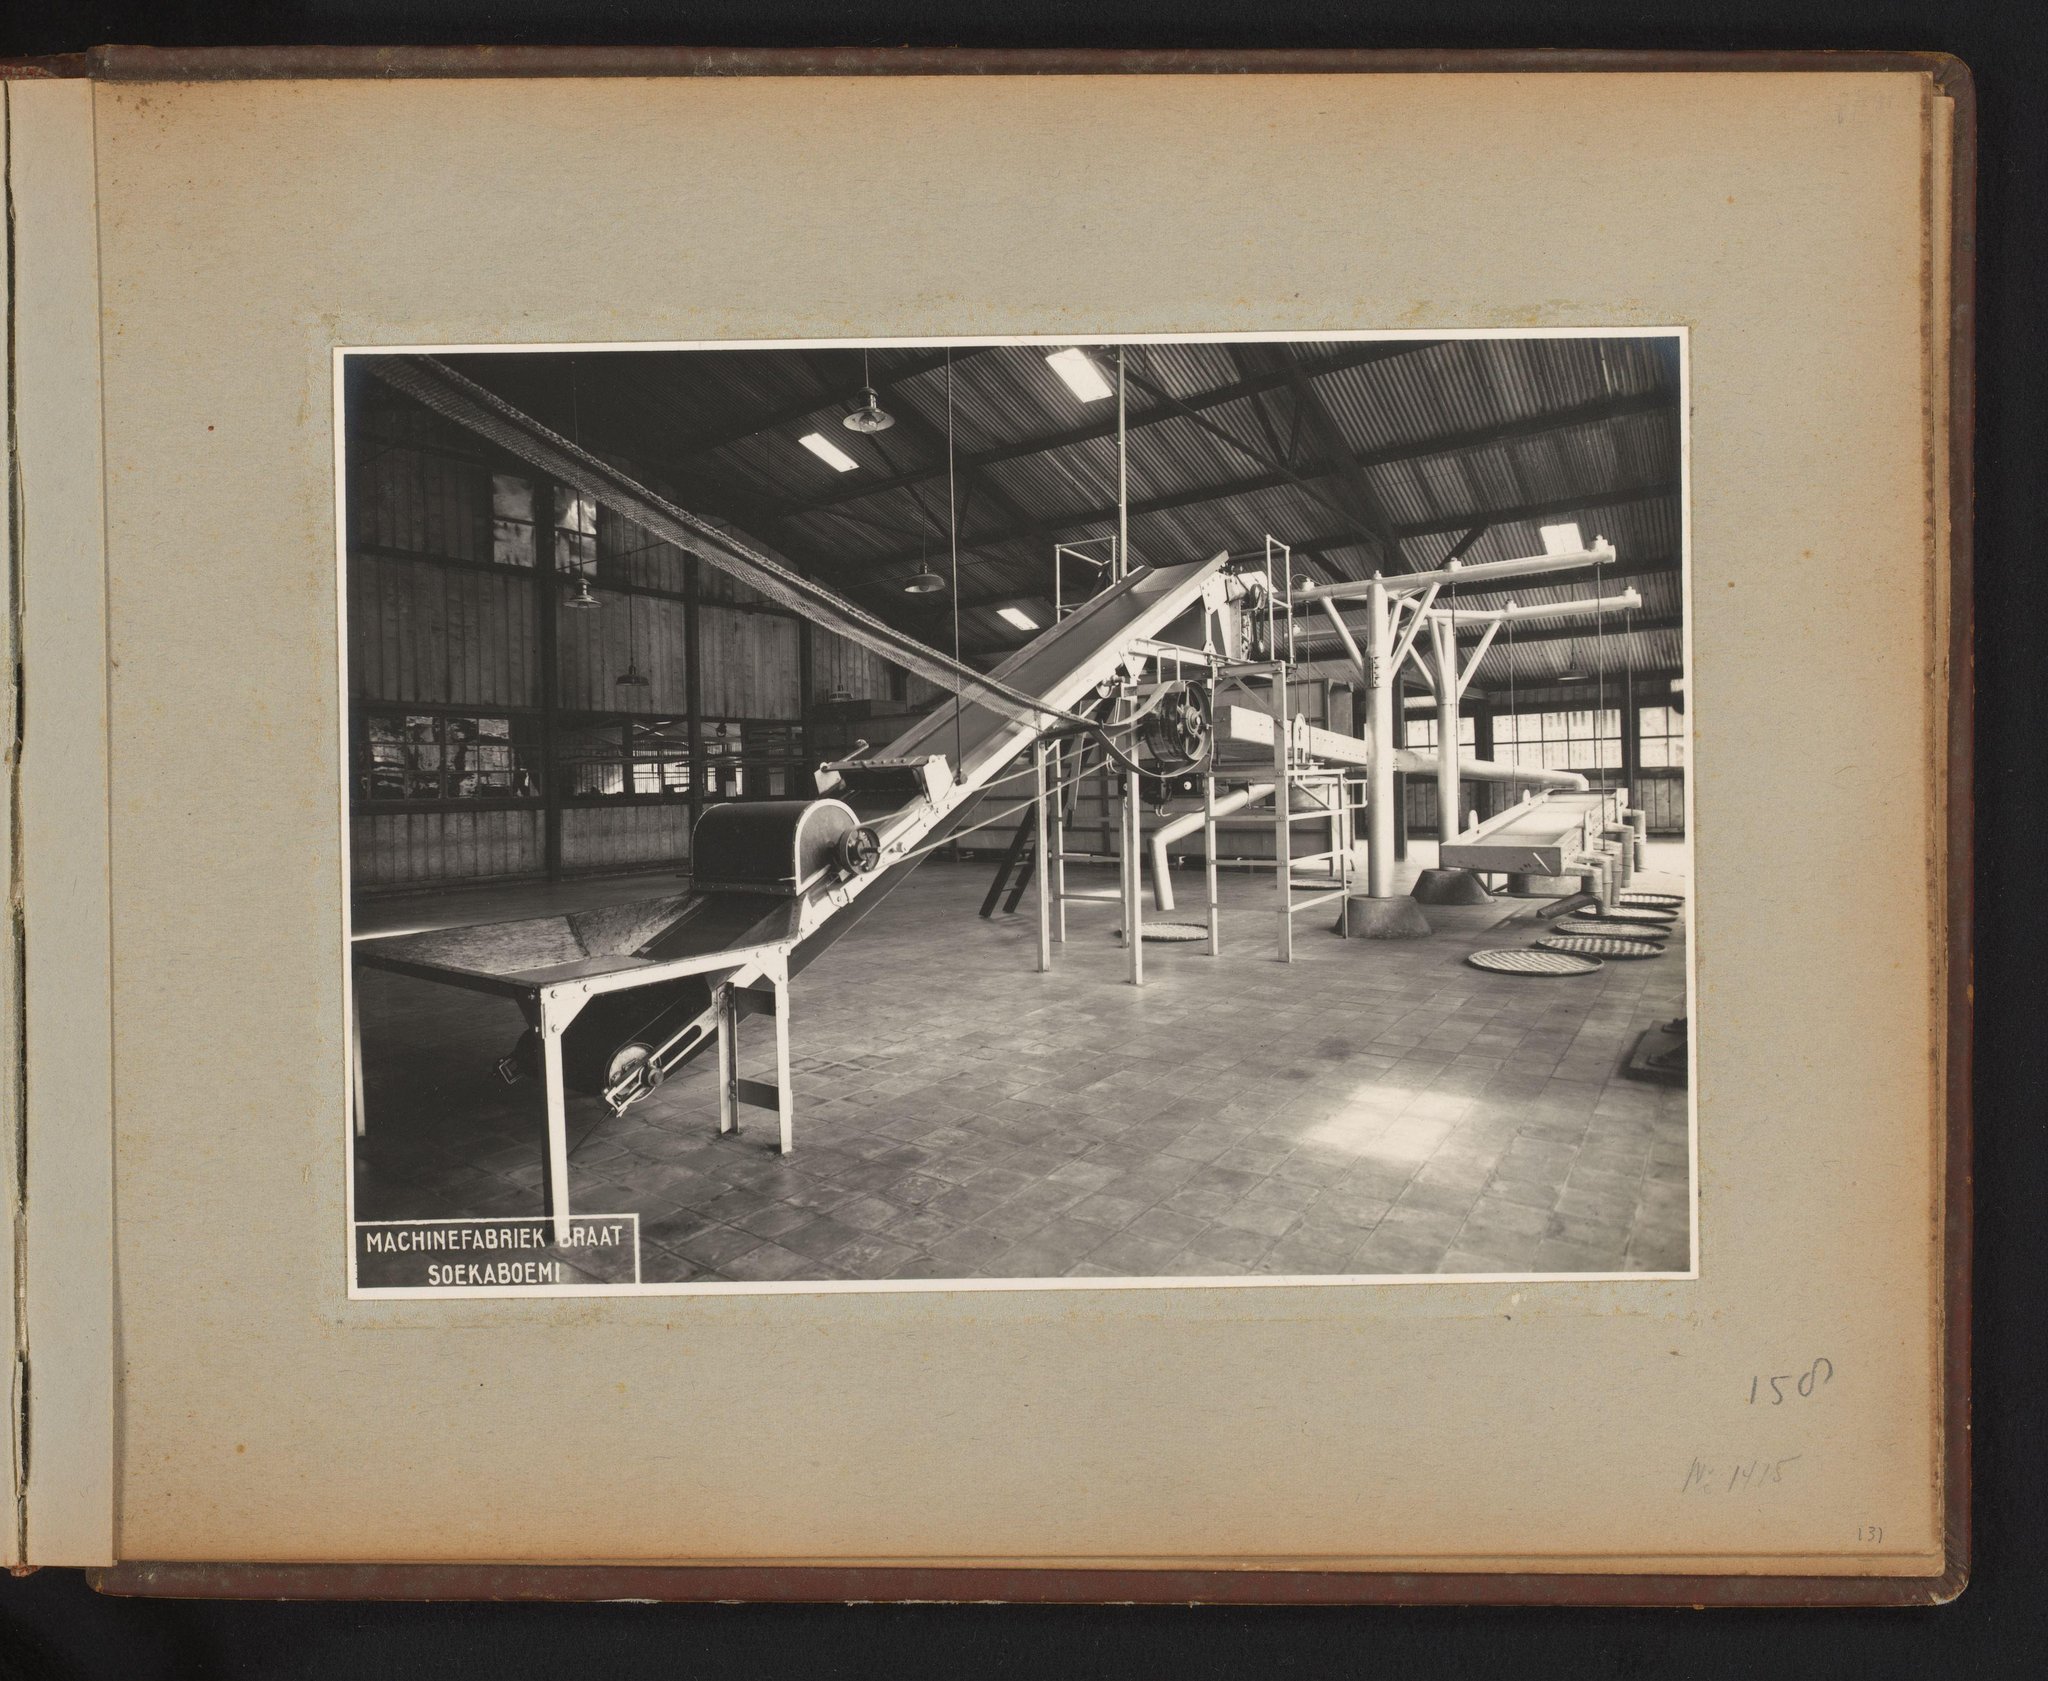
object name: album leaf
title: Installatie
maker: Anonymous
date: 1931-1937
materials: cardboard, photographic support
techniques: gelatin silver print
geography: soekaboemi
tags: factory-interior, machine shop, machines; parts of machines; tools and appliances, java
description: Albumblad met een foto van een installatie met lopende banden. Ontworpen voor of door N.V. Technisch Bureau Van Assendelft De Coningh. Onderdeel van een fotoalbum met foto's van machines en constructies van de N.V. Machinefabriek Braat te Soerabaja, Soekaboemi en Tegal uit de periode 1931-1937.